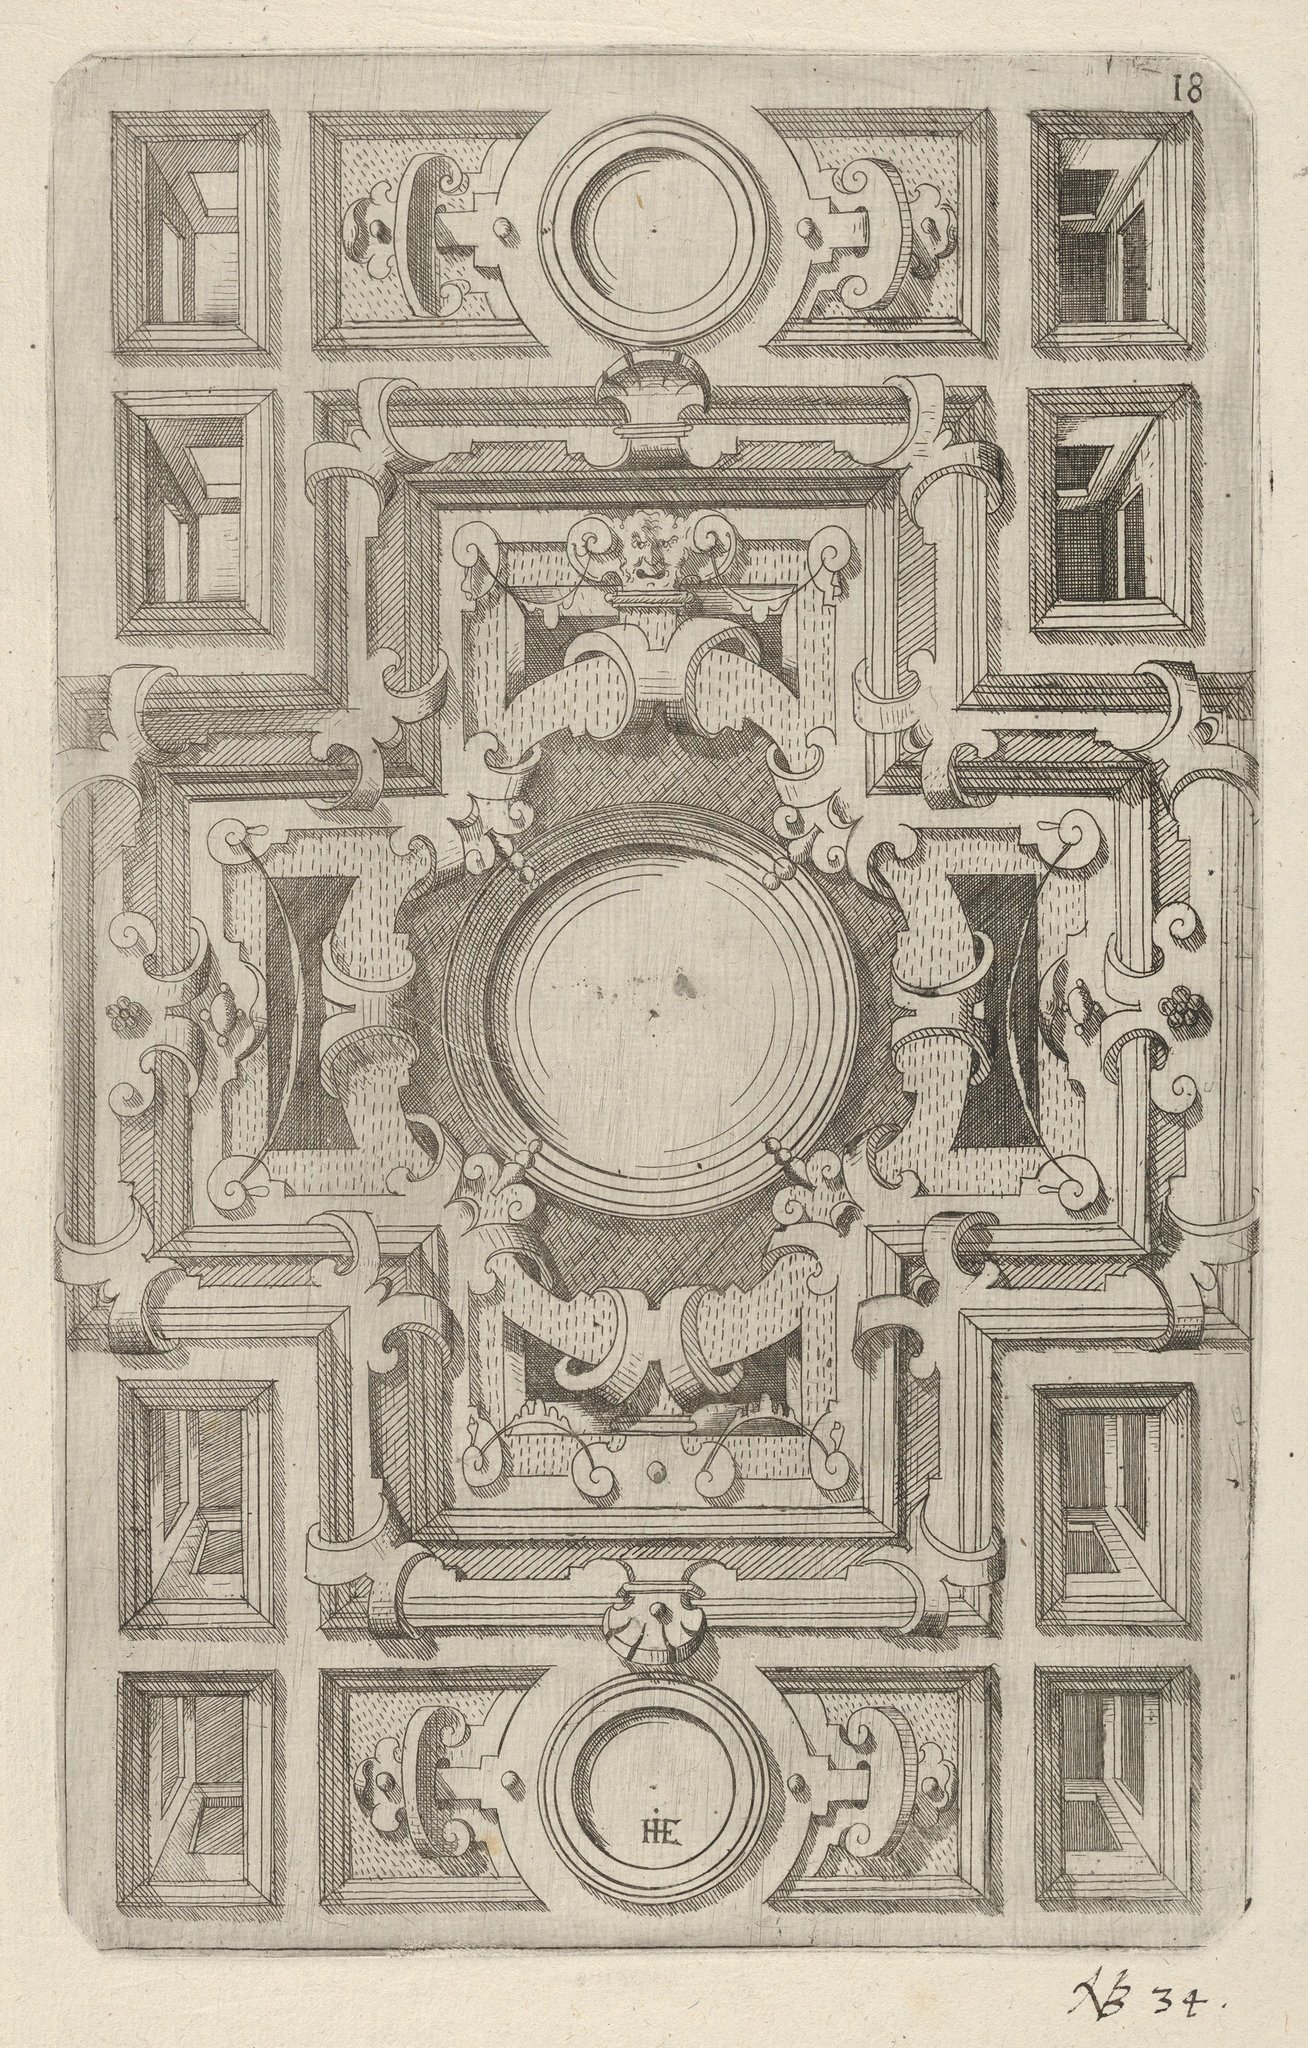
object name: print ornament architecture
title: Design for a Ceiling with Strapwork and a Cross-shaped Center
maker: hans jakob ebelmann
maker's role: artist and architect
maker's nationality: german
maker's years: 1570-1625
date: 1609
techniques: engraving, etching